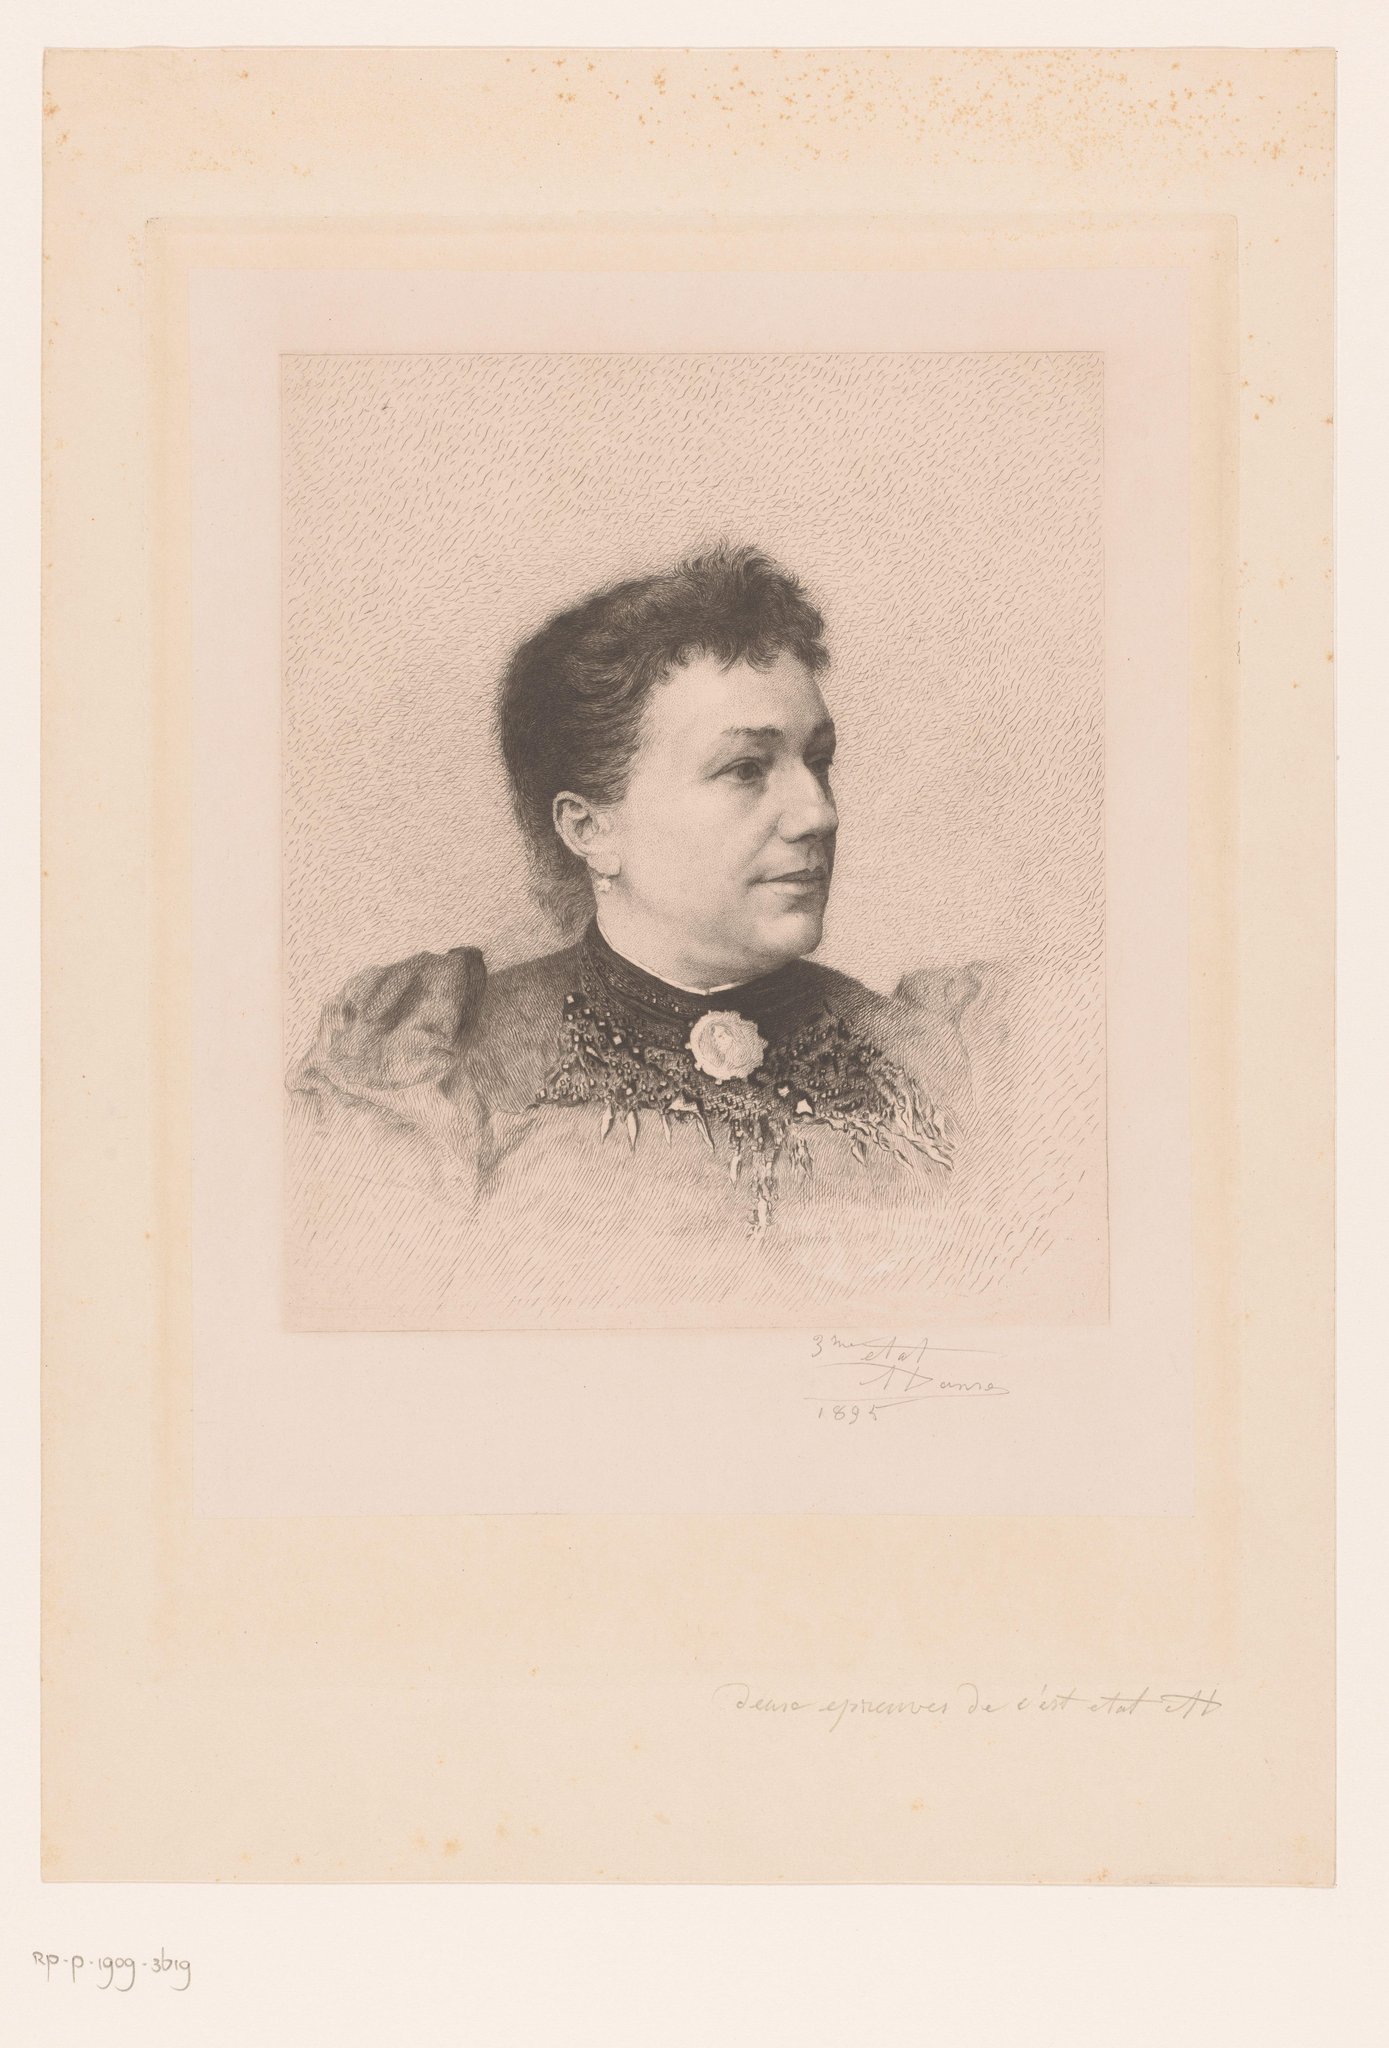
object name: print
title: Portret van een onbekende dame, mevrouw Panilecq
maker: auguste danse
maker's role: print maker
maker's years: 1829-1929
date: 1895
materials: paper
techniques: drypoint, etching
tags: anonymous historical person portrayed alone - bb - woman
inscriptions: annotation: ‘deux epreuves de c'est etat’, annotation: ‘3me état’, collector's mark: Lugt 2228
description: De naam Panilecq komt voor in een annotatie in de marge van een eerdere staat van deze prent.